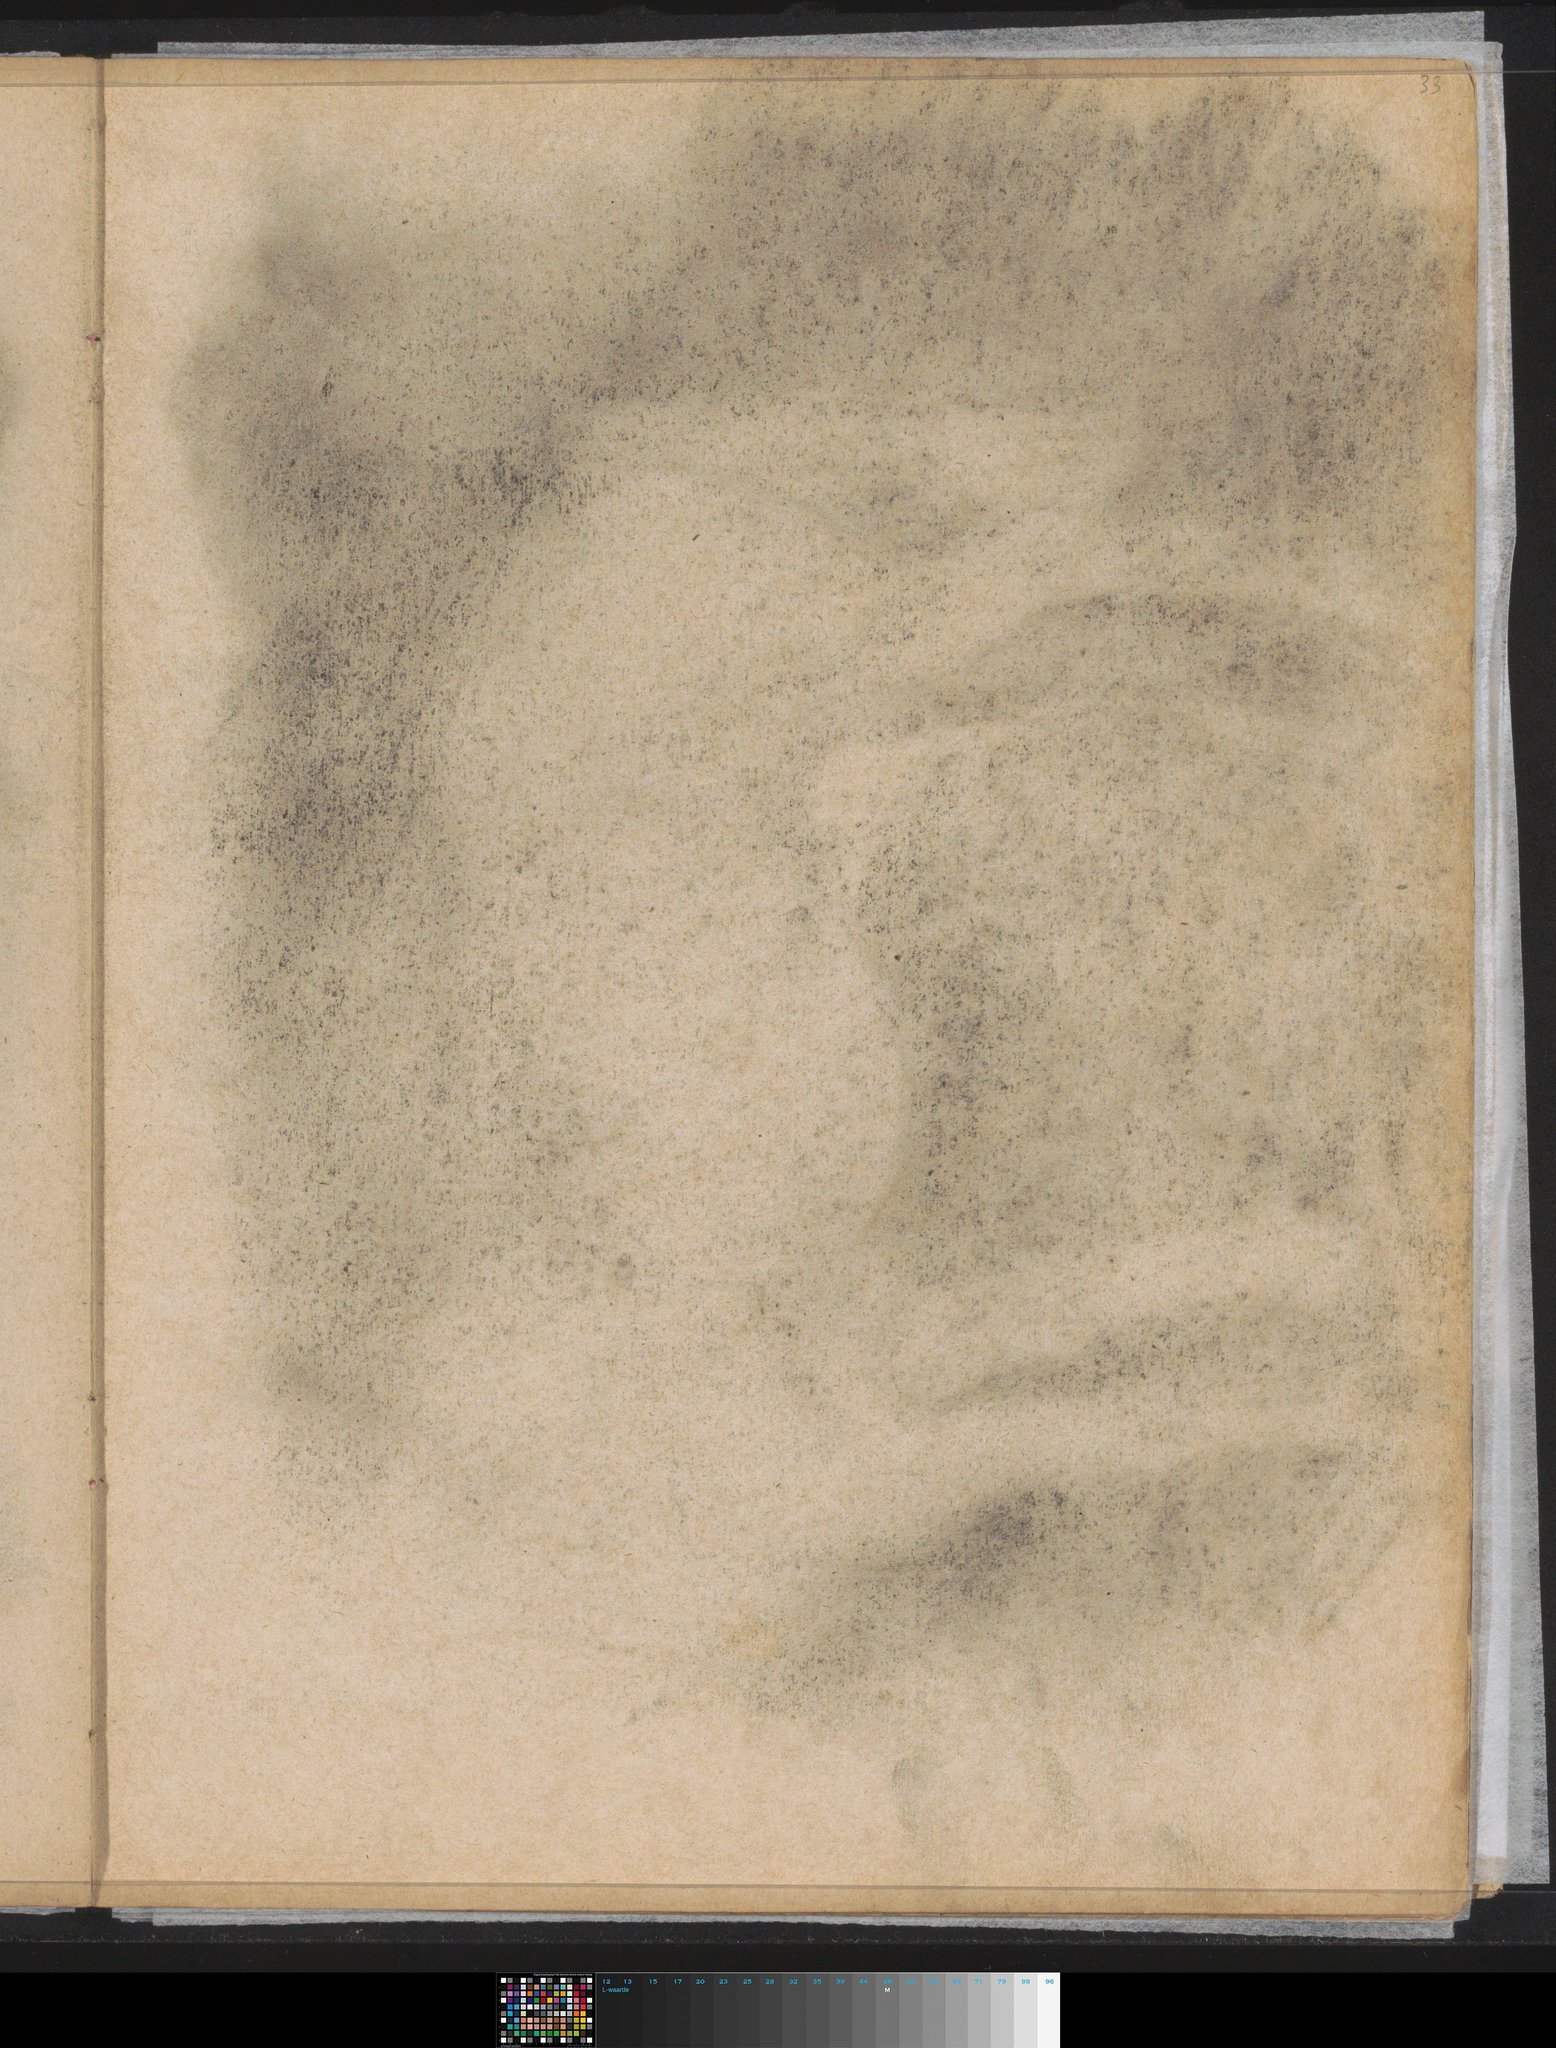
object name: sketchbook leaf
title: Abklatsch van de krijttekening op pagina 32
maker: willem witsen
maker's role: draughtsman, painter, print maker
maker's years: 1860-1923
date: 1887-1891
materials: paper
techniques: printmaking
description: Pagina 33 uit een schetsboek met 29 bladen.